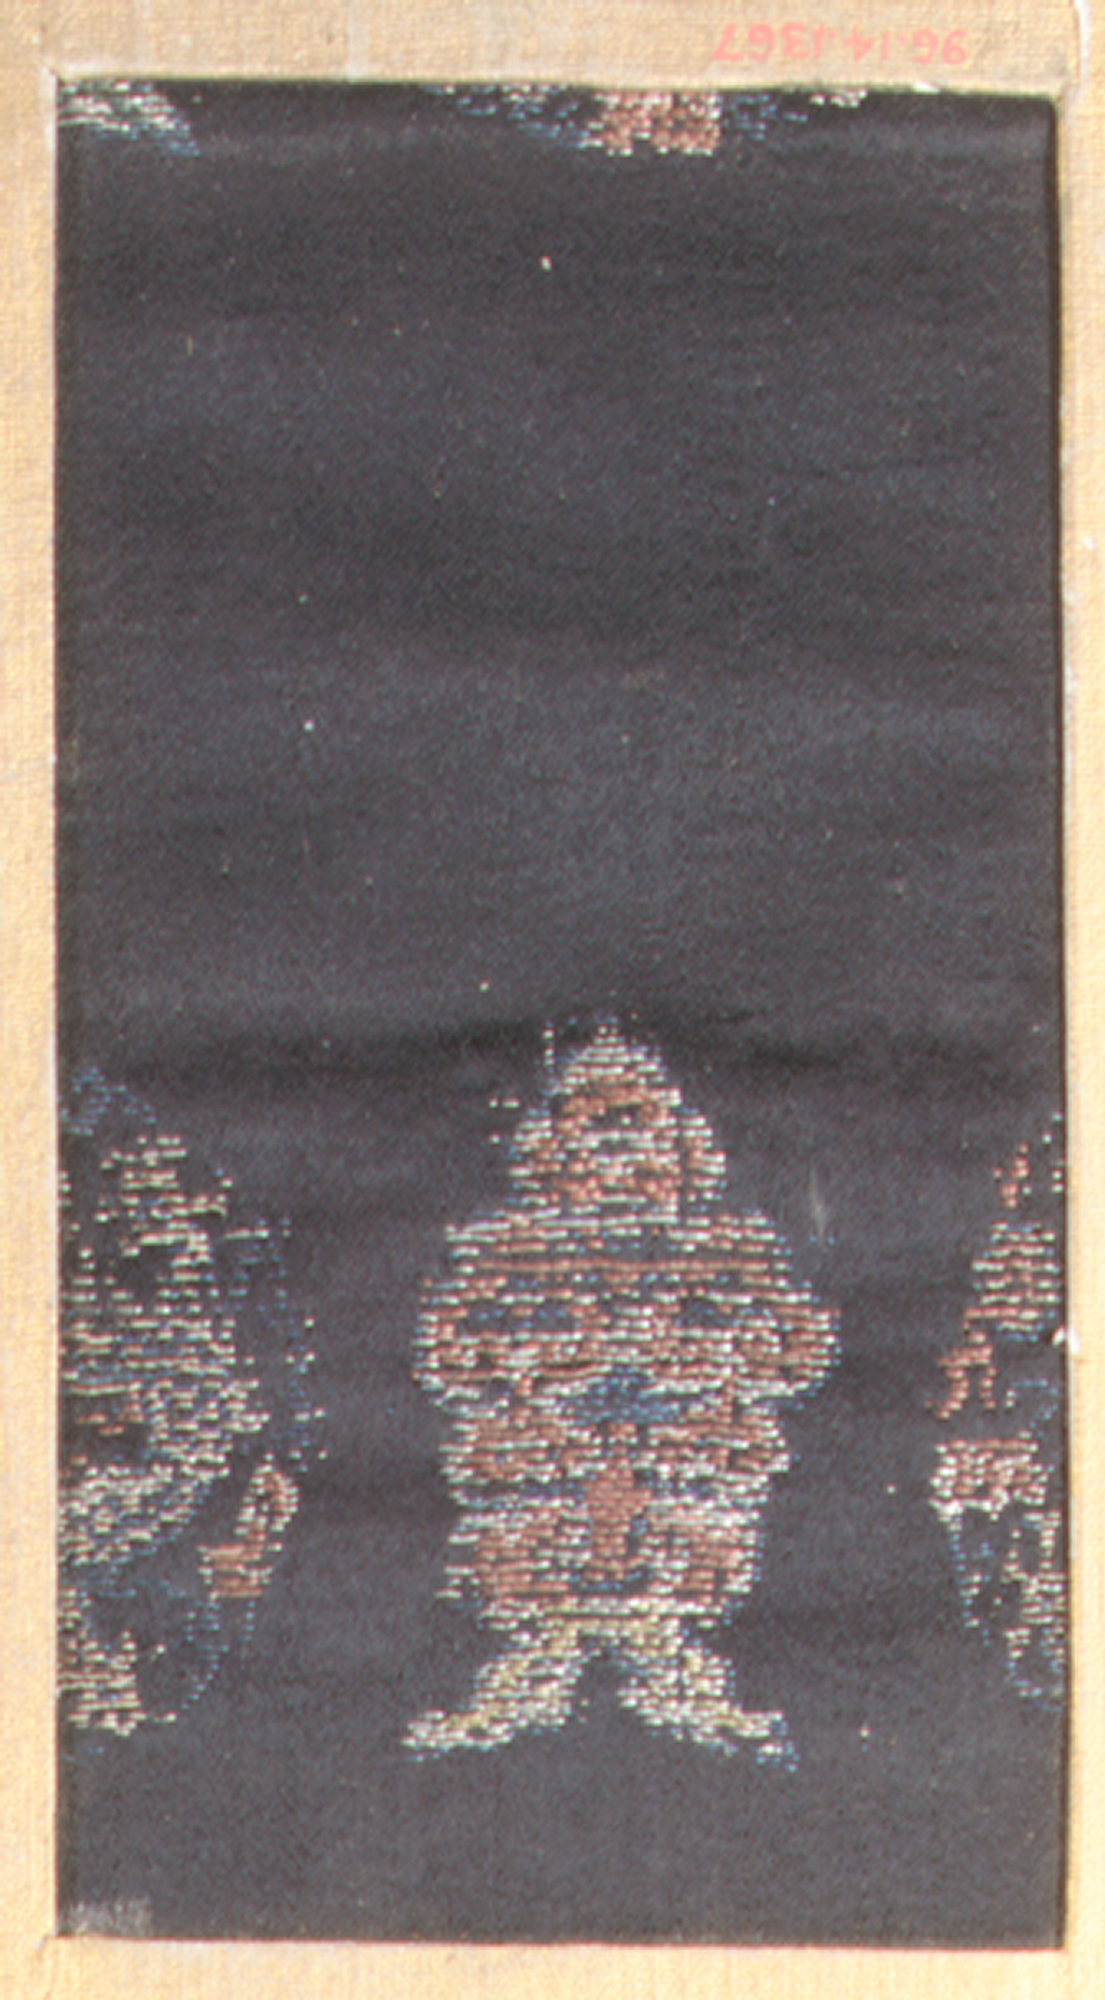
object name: piece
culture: japanese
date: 1701-1900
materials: silk